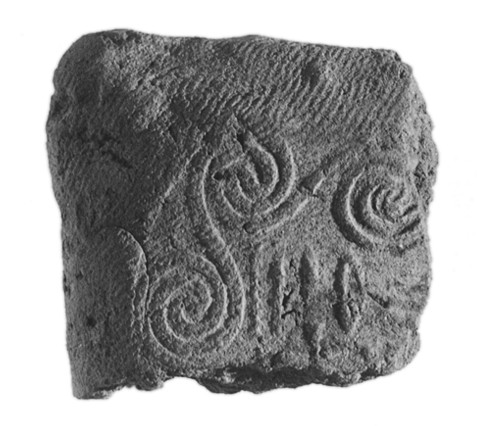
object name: sealing, administrative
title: Administrative Seal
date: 1981-1640 BCE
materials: clay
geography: egypt